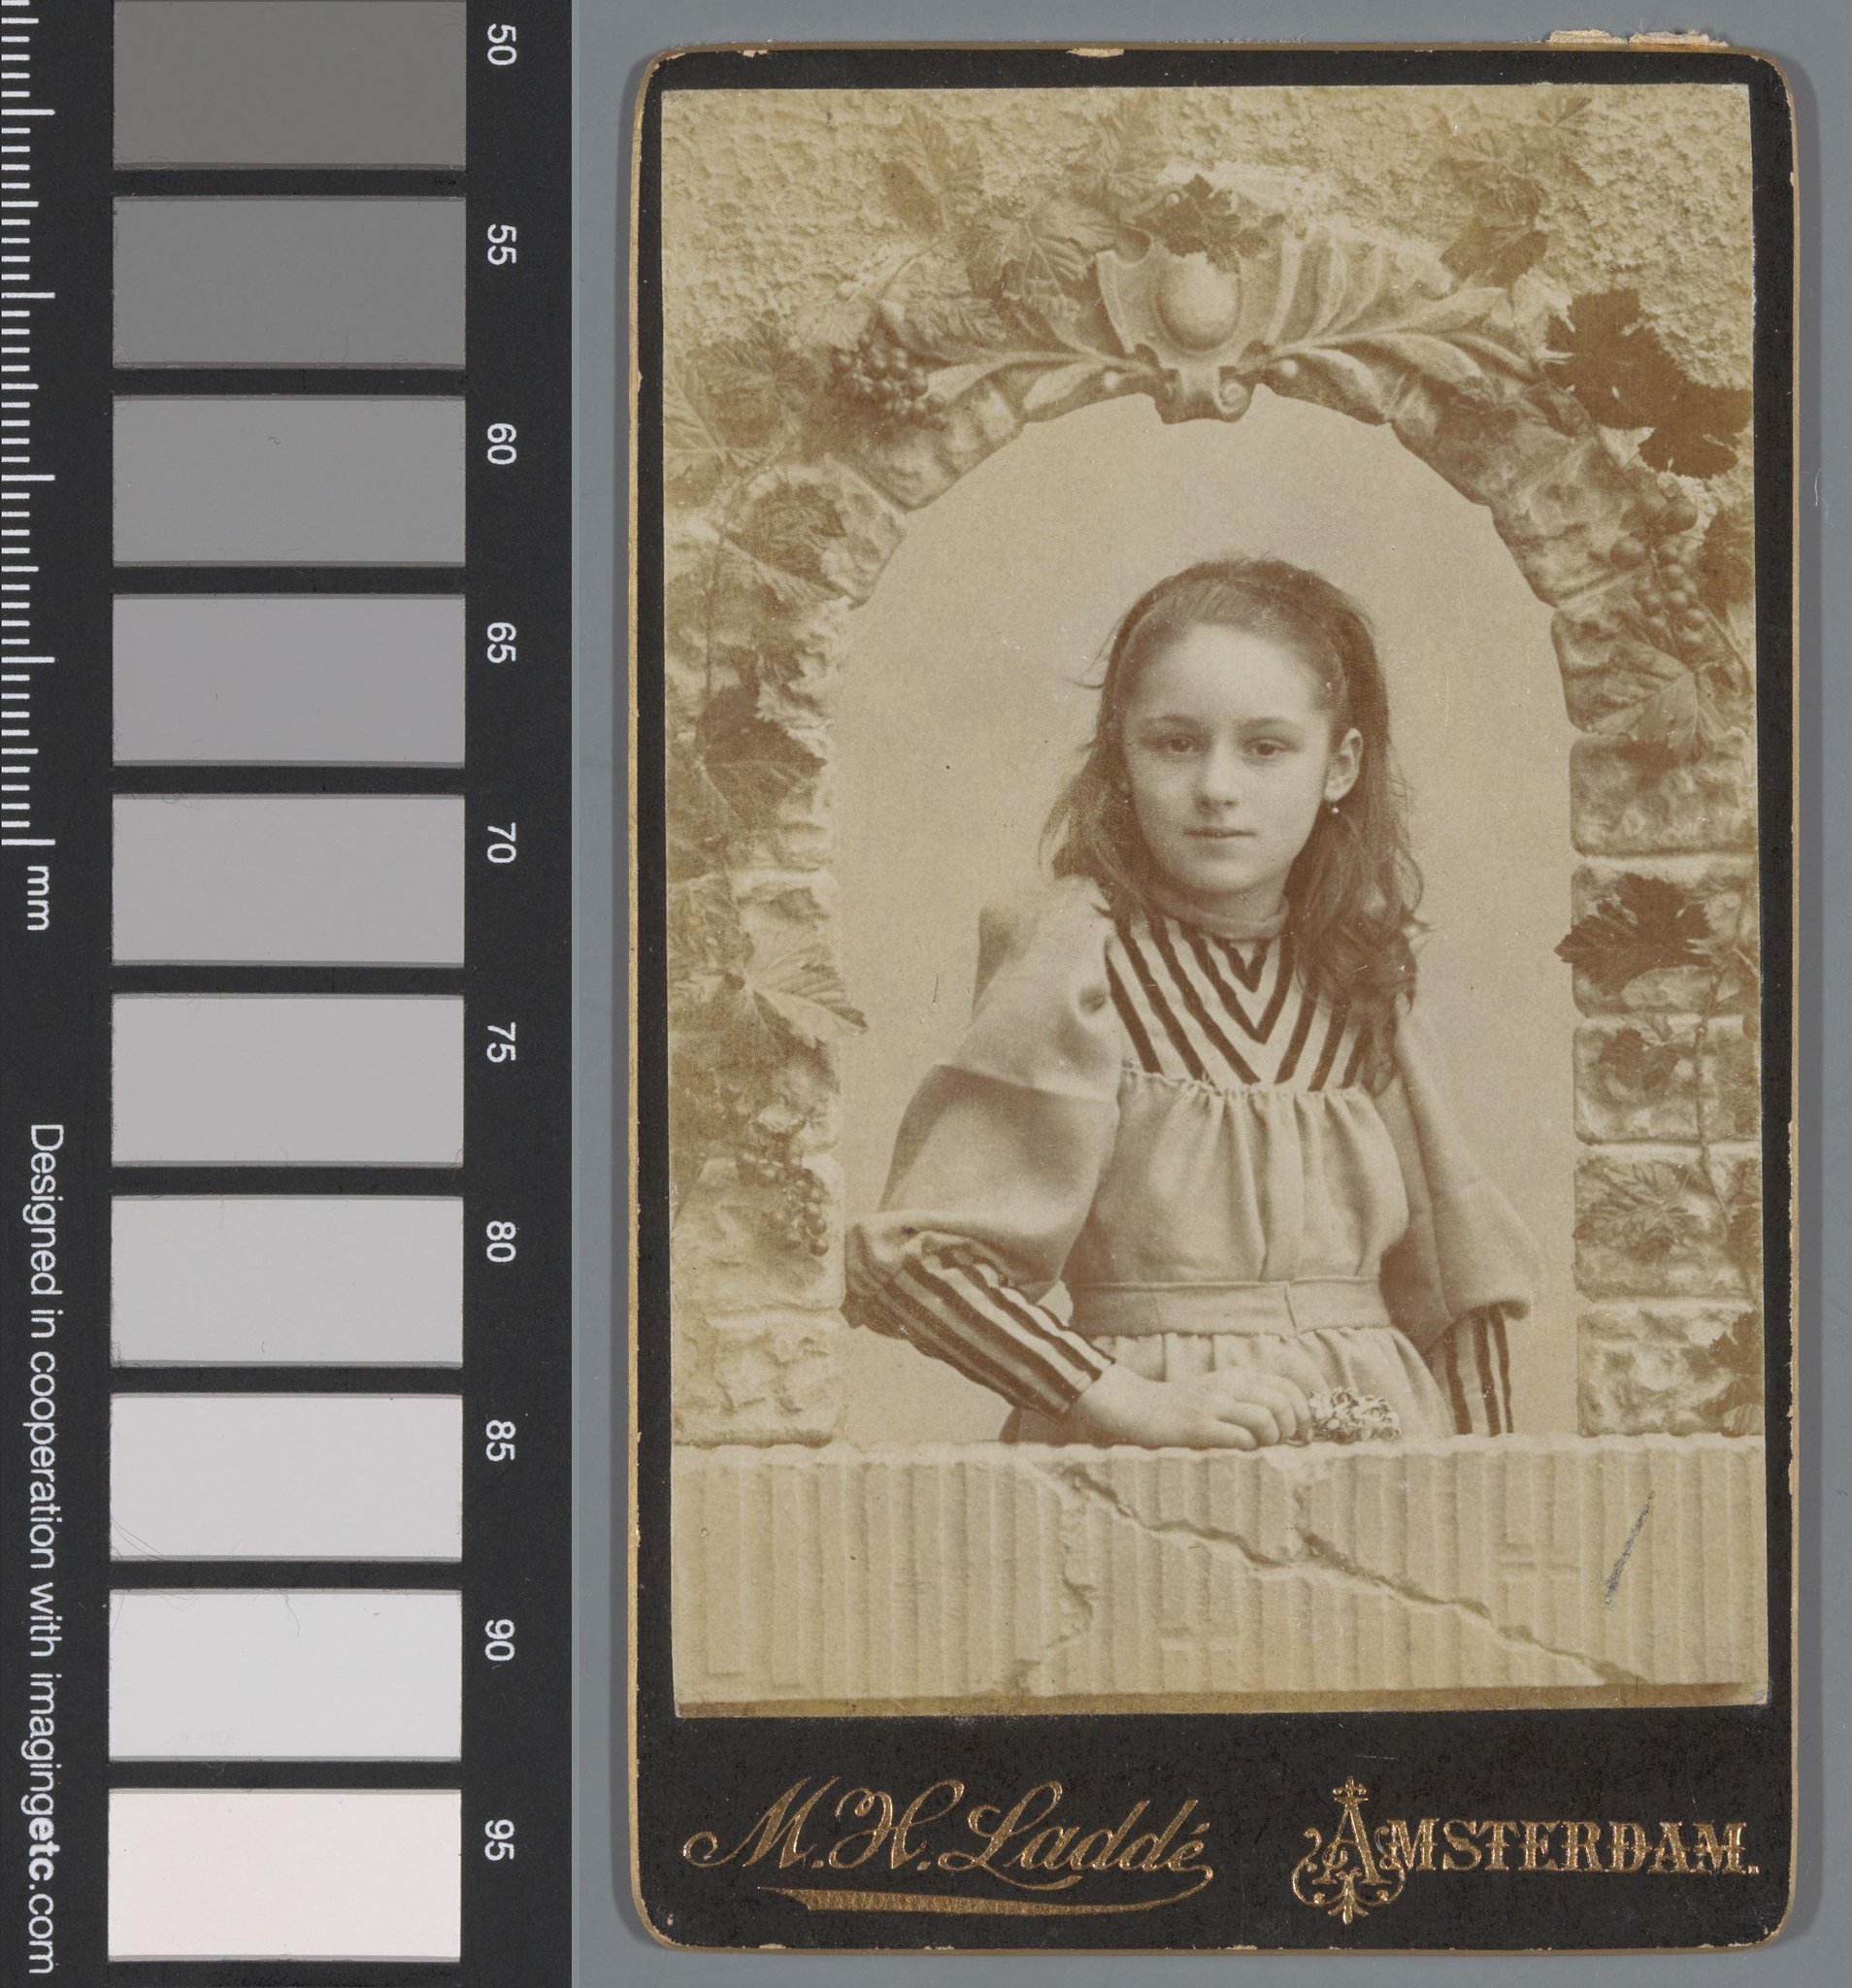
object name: photograph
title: Portret van een onbekend meisje in een venster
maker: machiel hendricus laddé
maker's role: fotograaf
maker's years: 1866-1932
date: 1892-1906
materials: paper, cardboard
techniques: gelatin silver print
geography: amsterdam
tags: girl (child between toddler and youth), anonymous historical person portrayed, open window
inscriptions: address: ‘AMSTERDAM/ Nieuwendyk 59.’